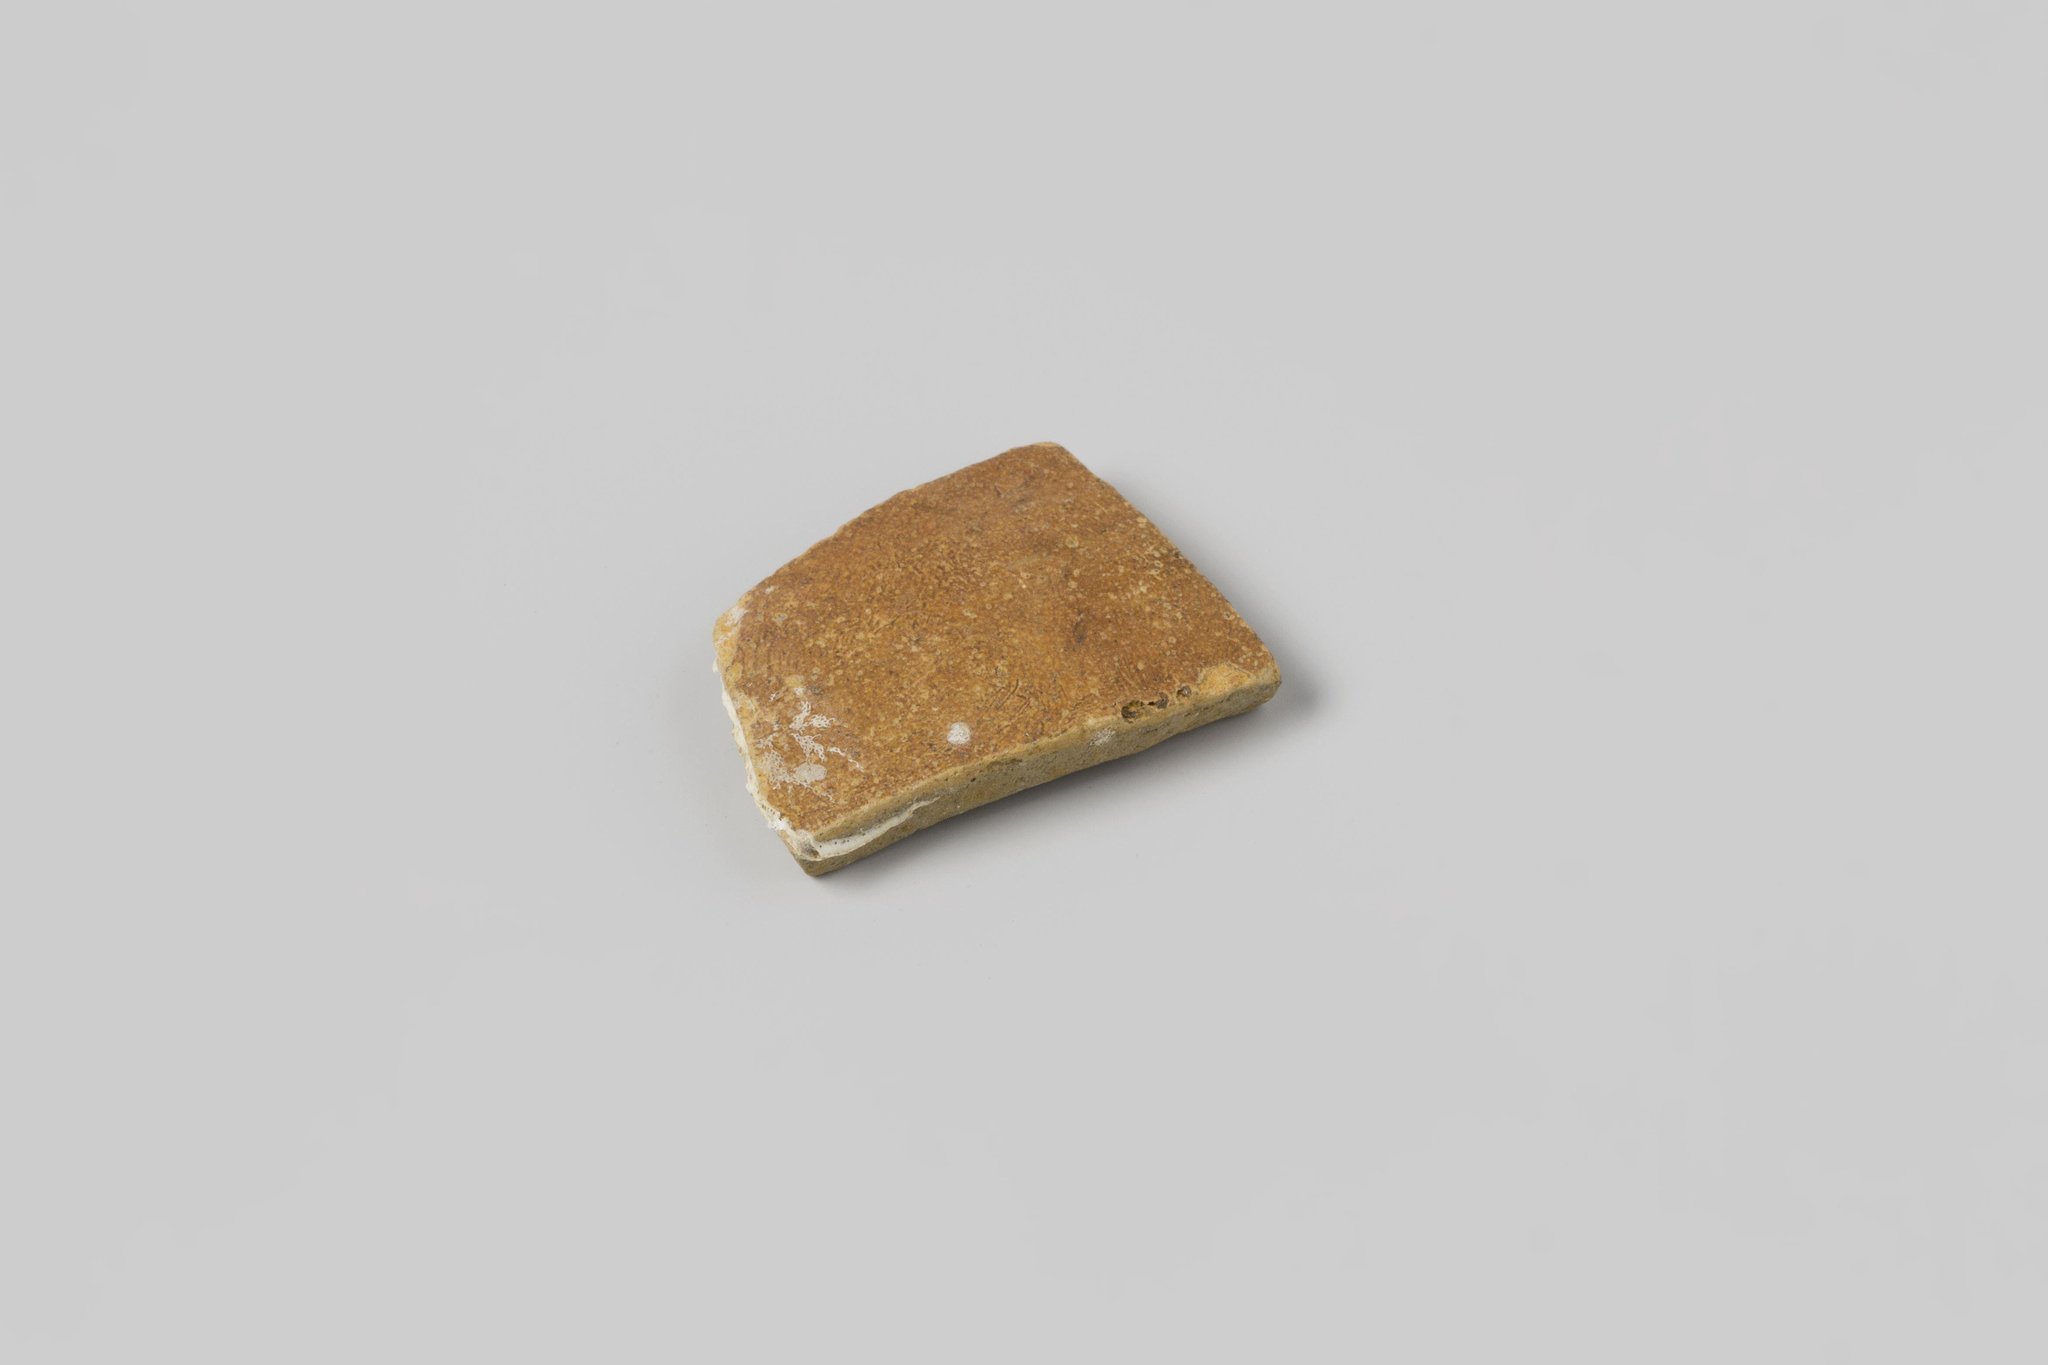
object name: sherd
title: Scherf van een kan uit het wrak van de Oost-Indiëvaarder Hollandia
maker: Anonymous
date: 1700-1743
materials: stoneware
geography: cologne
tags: verenigde oostindische compagnie, hollandia (schip), annet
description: Stoneware, Rhenish, Frechen-ware, jug; fragm of body.